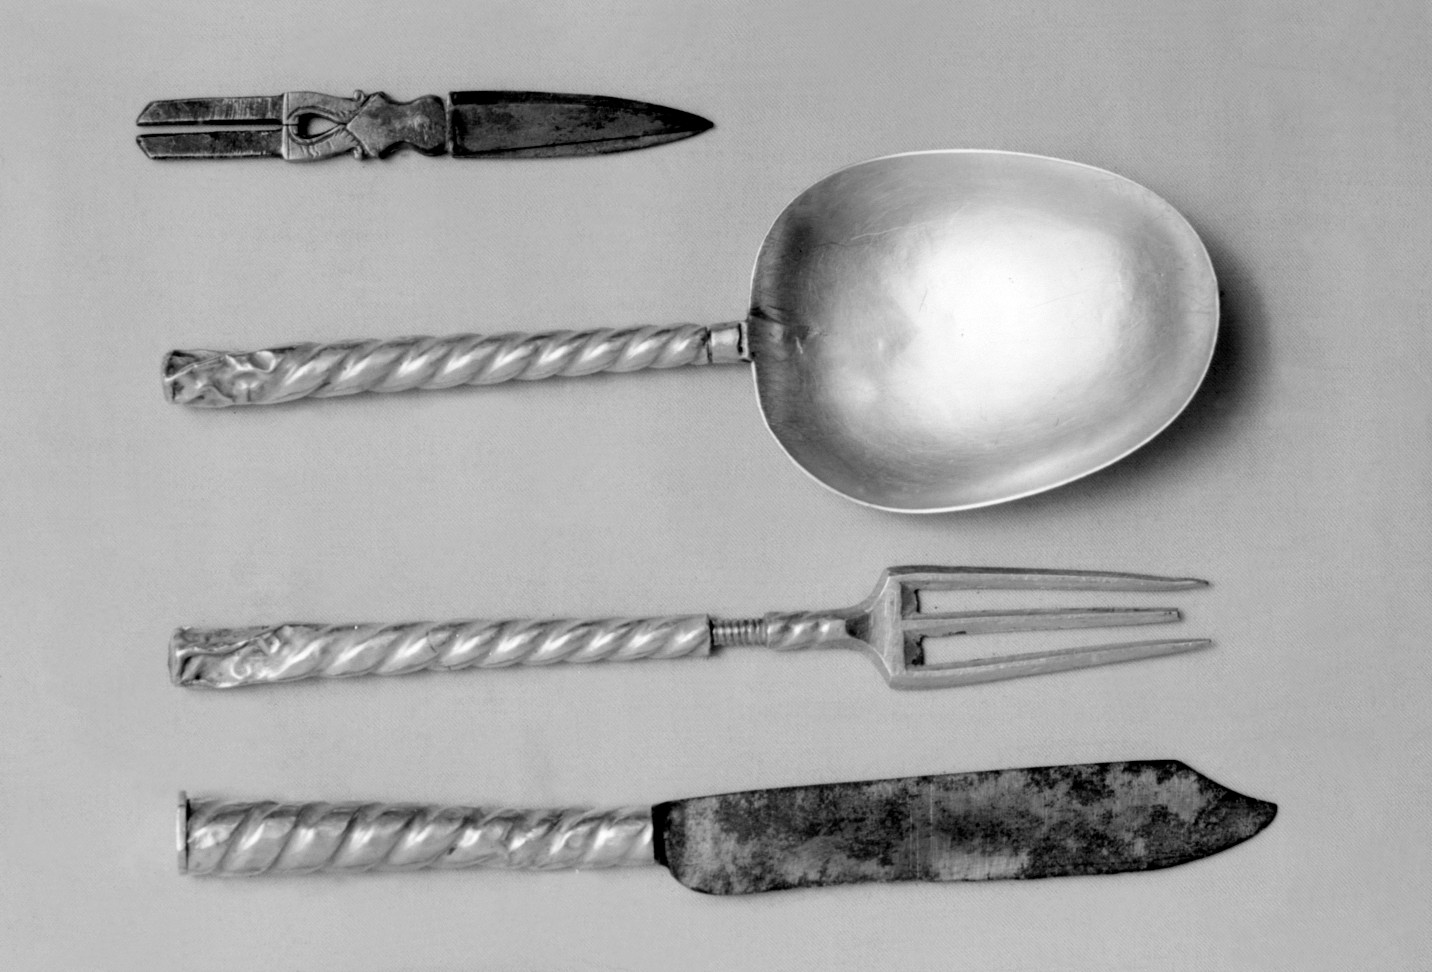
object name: traveling set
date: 1601-1700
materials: leather, silver, steel